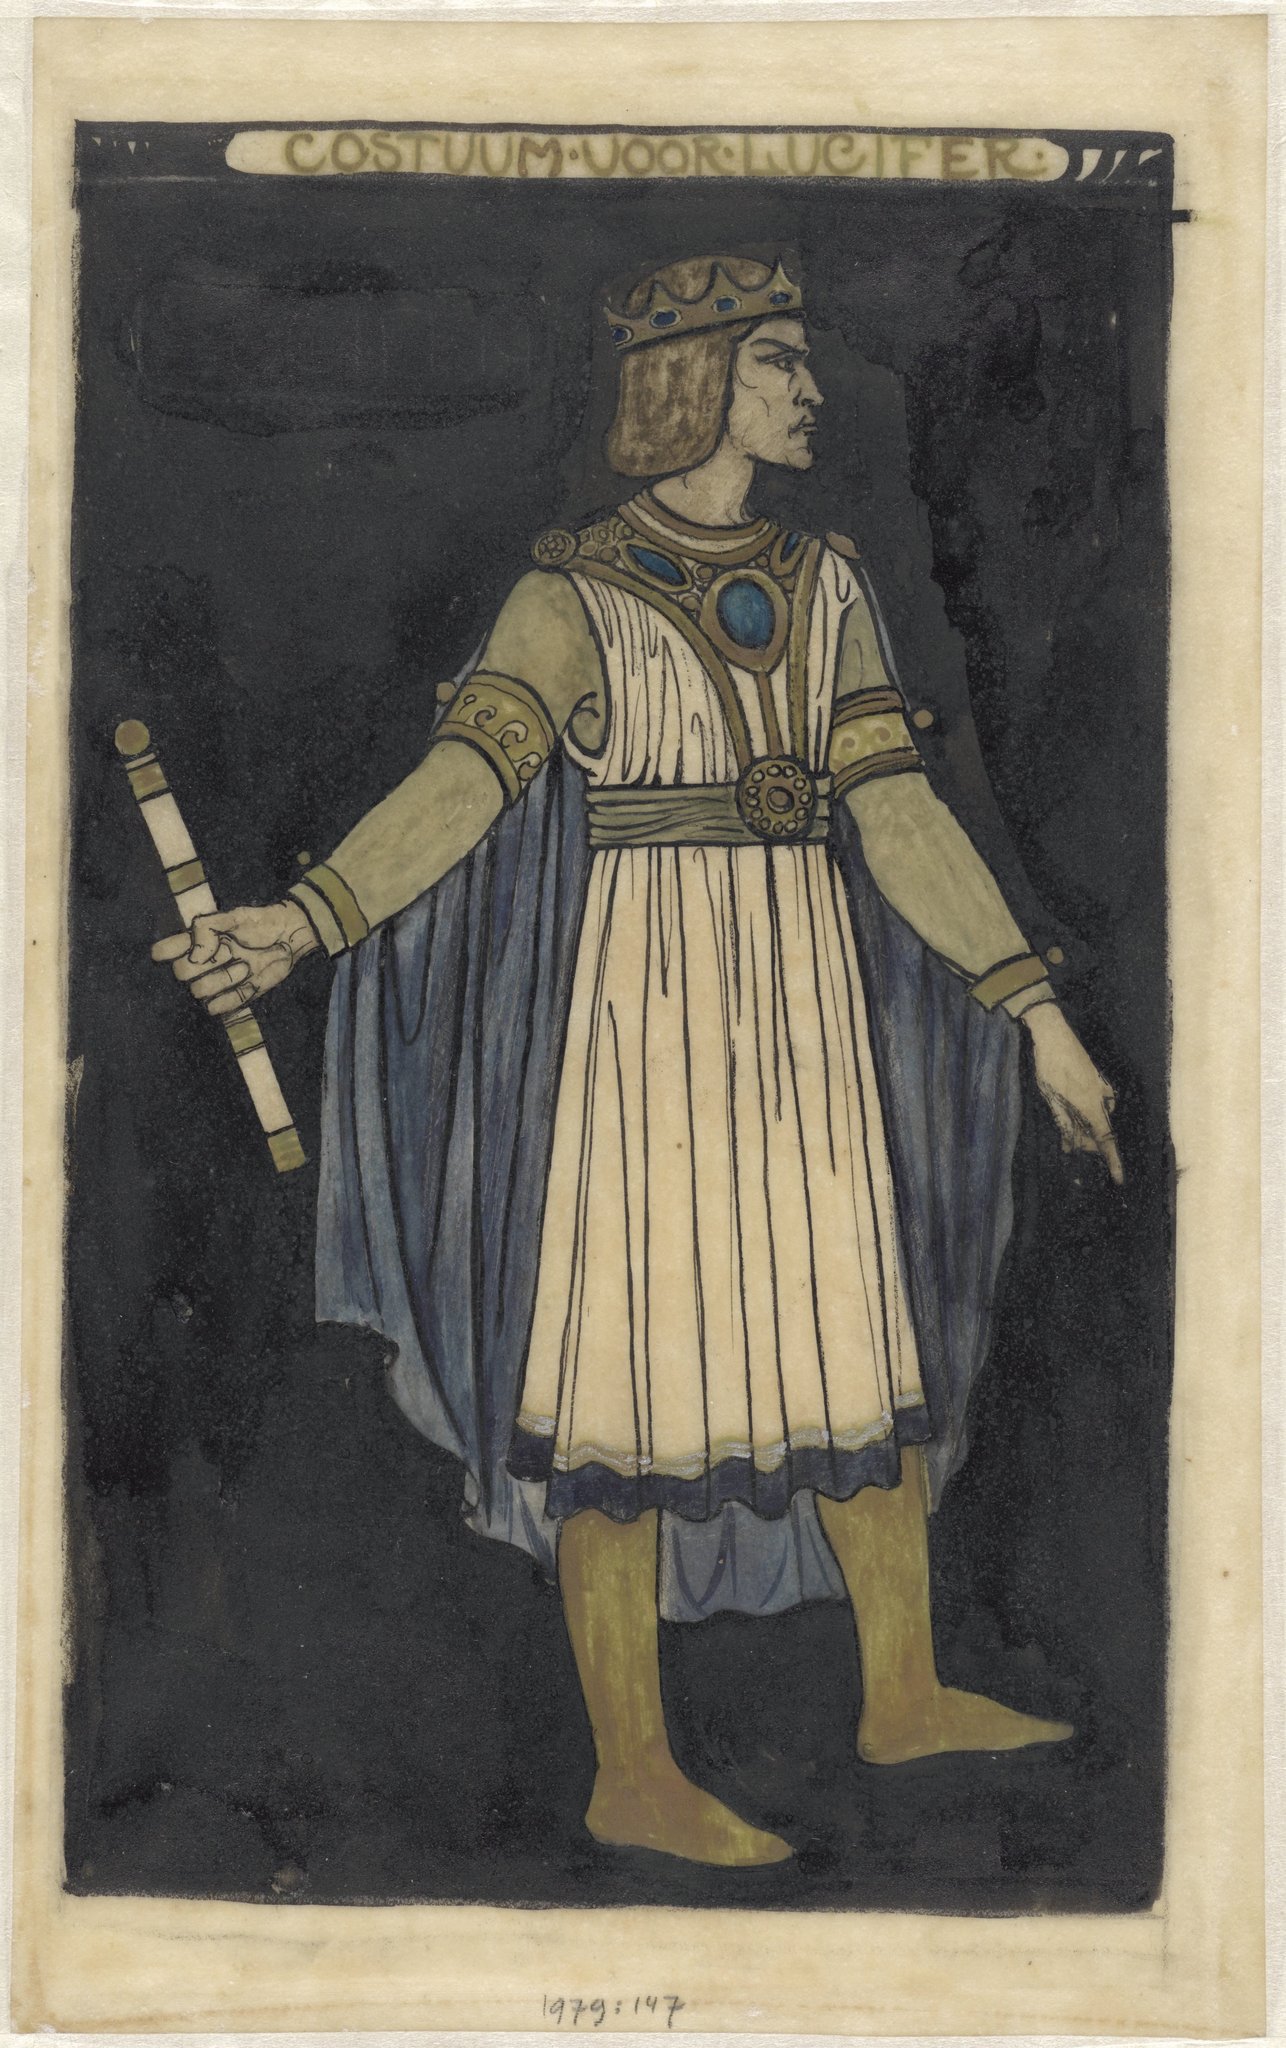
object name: design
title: Ontwerp voor kostuum voor Lucifer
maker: richard nicolaüs roland holst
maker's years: 1868-1938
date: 1878-1938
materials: ink, parchment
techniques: brush, pen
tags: male literary characters (lucifer), stage costume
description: Kostuumontwerp voor Lucifer, personage uit het toneelstuk 'Lucifer' door Joost van den Vondel.